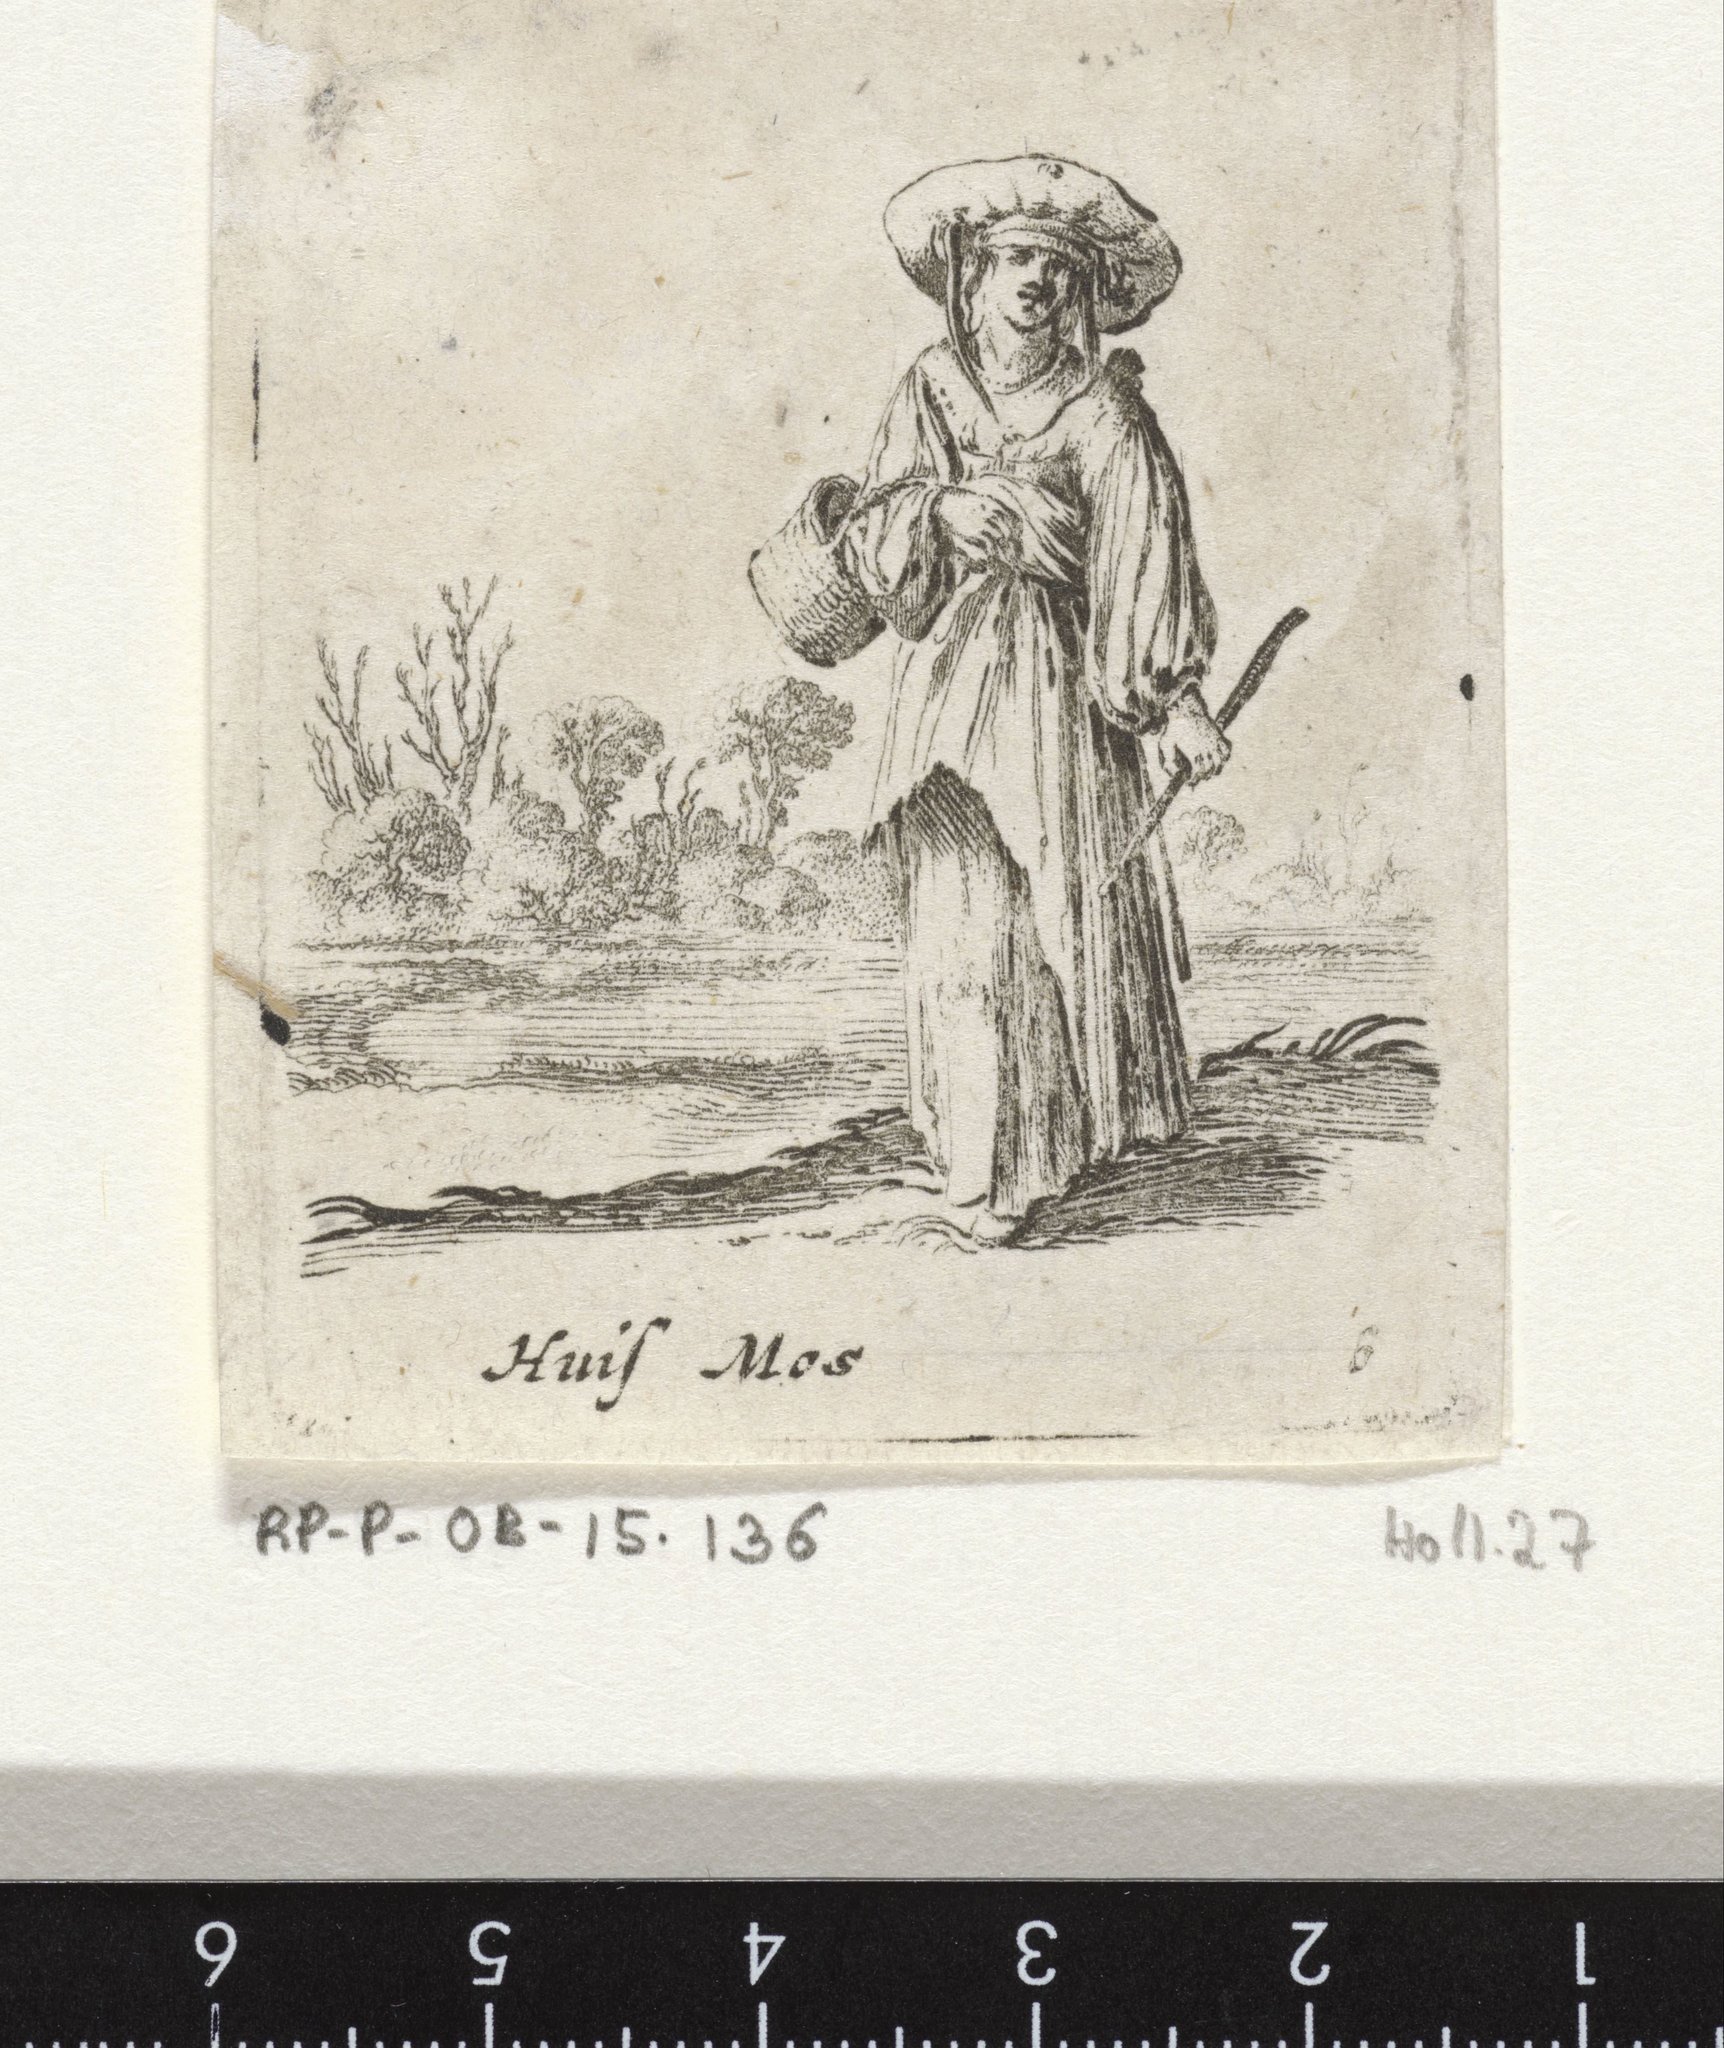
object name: print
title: Huis Mos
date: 1630-1706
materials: paper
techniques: engraving, etching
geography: amsterdam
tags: carrying something in basket, bag, rucksack, etc.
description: Bij een rivier staat een vrouw met op het hoofd een hoed en om de arm een mand. De prent maakt deel uit van een serie van 32 prenten met genretaferelen.